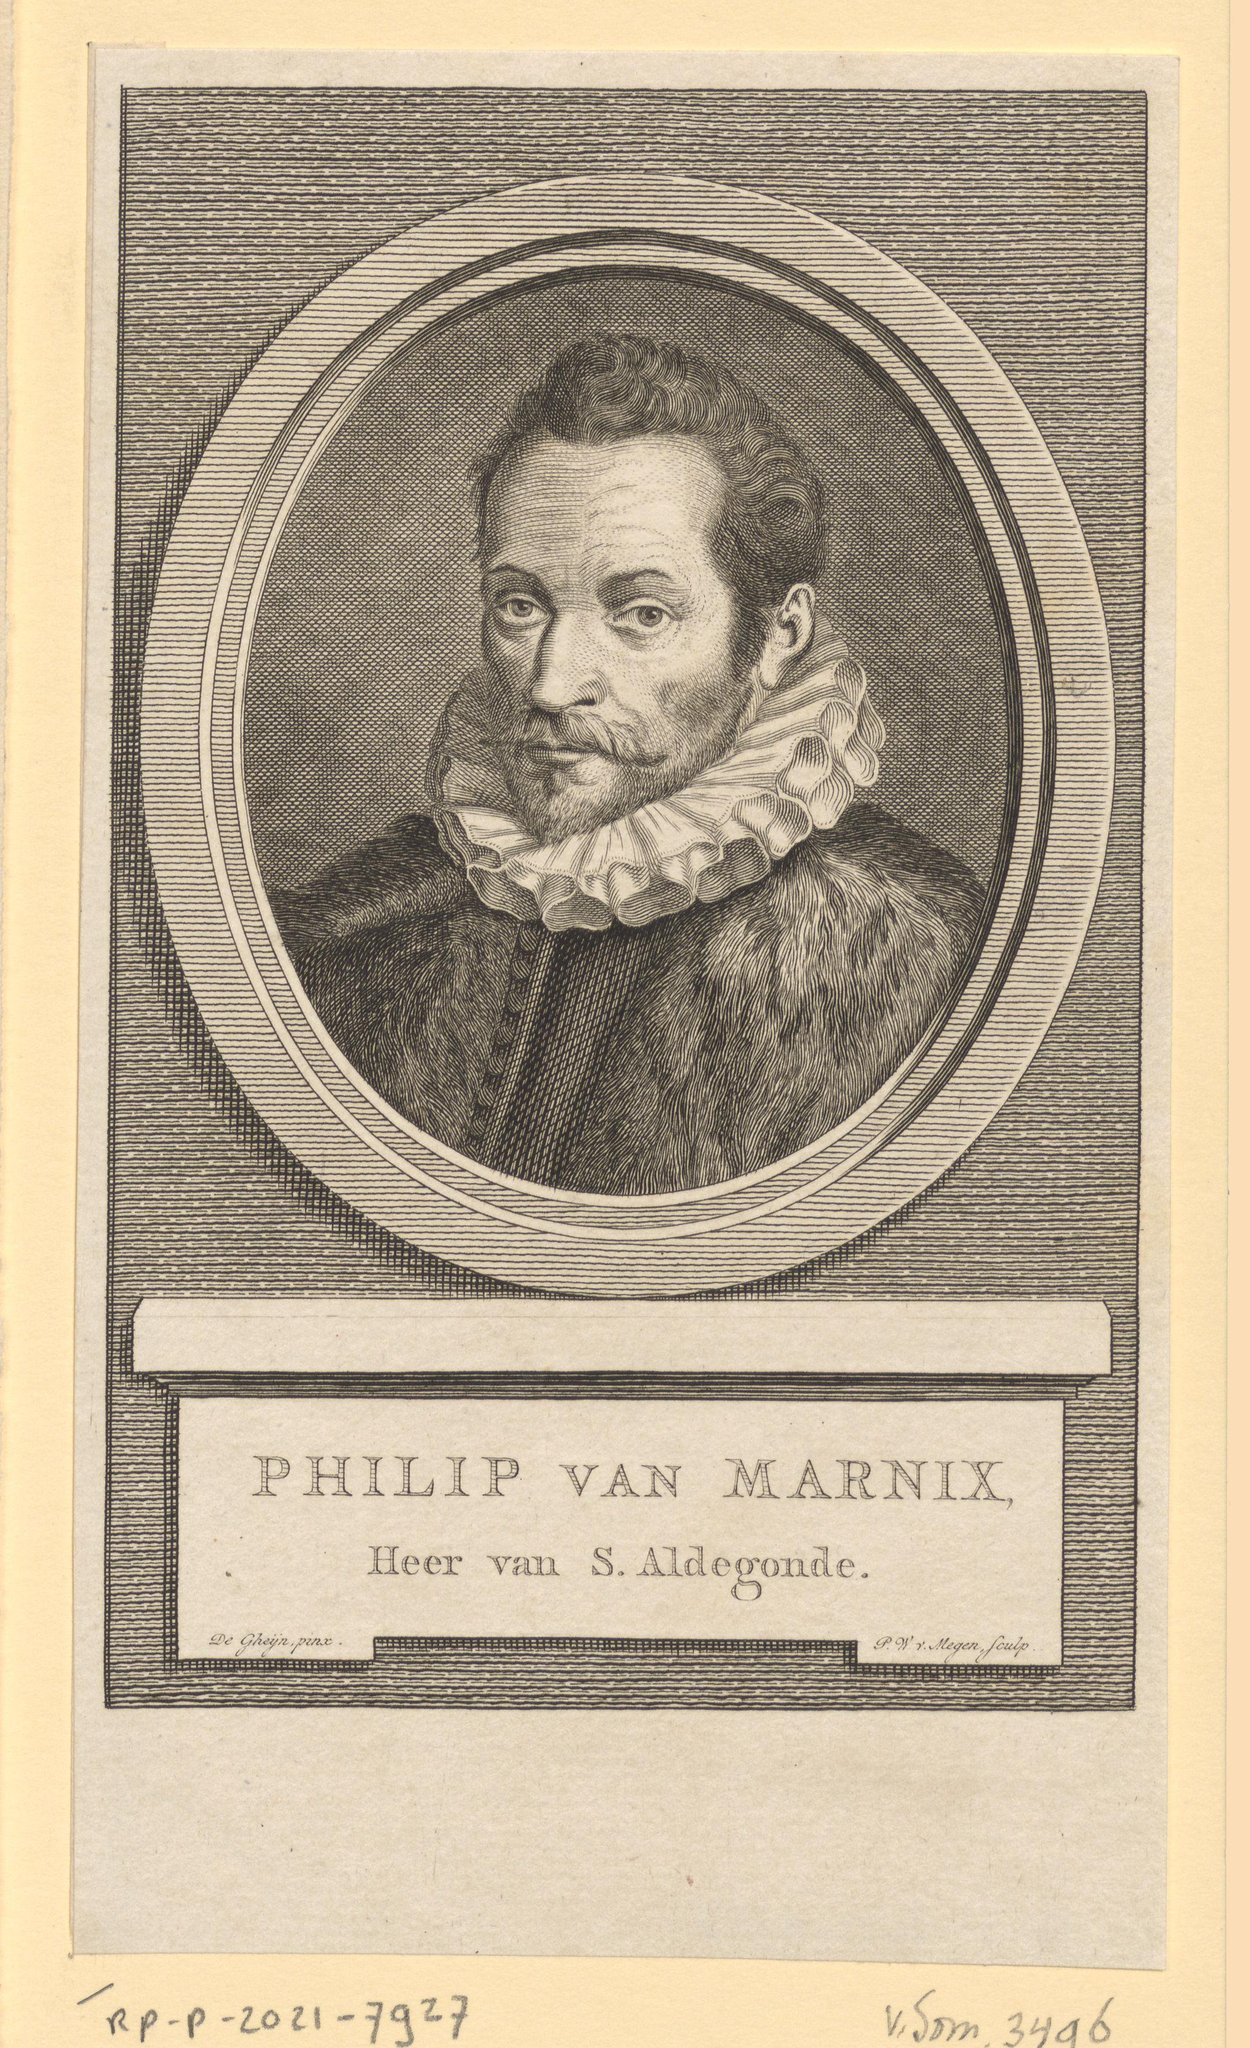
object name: print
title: Portret van Filips van Marnix van Sint-Aldegonde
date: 1760-1785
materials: paper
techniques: engraving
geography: the hague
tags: brussels, leiden, politician, filips van marnix van sint-aldegonde, ornament ~ medallion, historical persons, portrait of a writer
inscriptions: inscription: ‘Pecker’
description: De eerste drie staten zijn proefdrukken zonder onderschrift. Op de eerste staat, staat rechtsonder 'V. Meegen'. Op de tweede staat is dit signatuur verwijderd. Op de derde staat is de streep rechtsonder (ongeveer in het midden van het veld voor het onderschrift) verwijderd. Bij deze vierde staat zijn het onderschrift en namen van de kunstenaars toegevoegd.